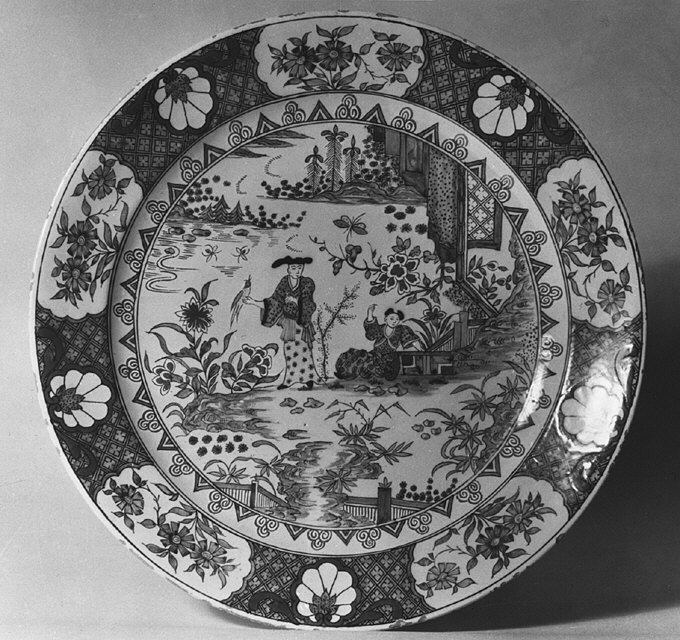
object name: plate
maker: adam friedrich von löwenfinck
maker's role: decorator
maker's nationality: german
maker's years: 1714-1754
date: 1801-1900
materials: faience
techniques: glazing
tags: chinoiserie,flowers